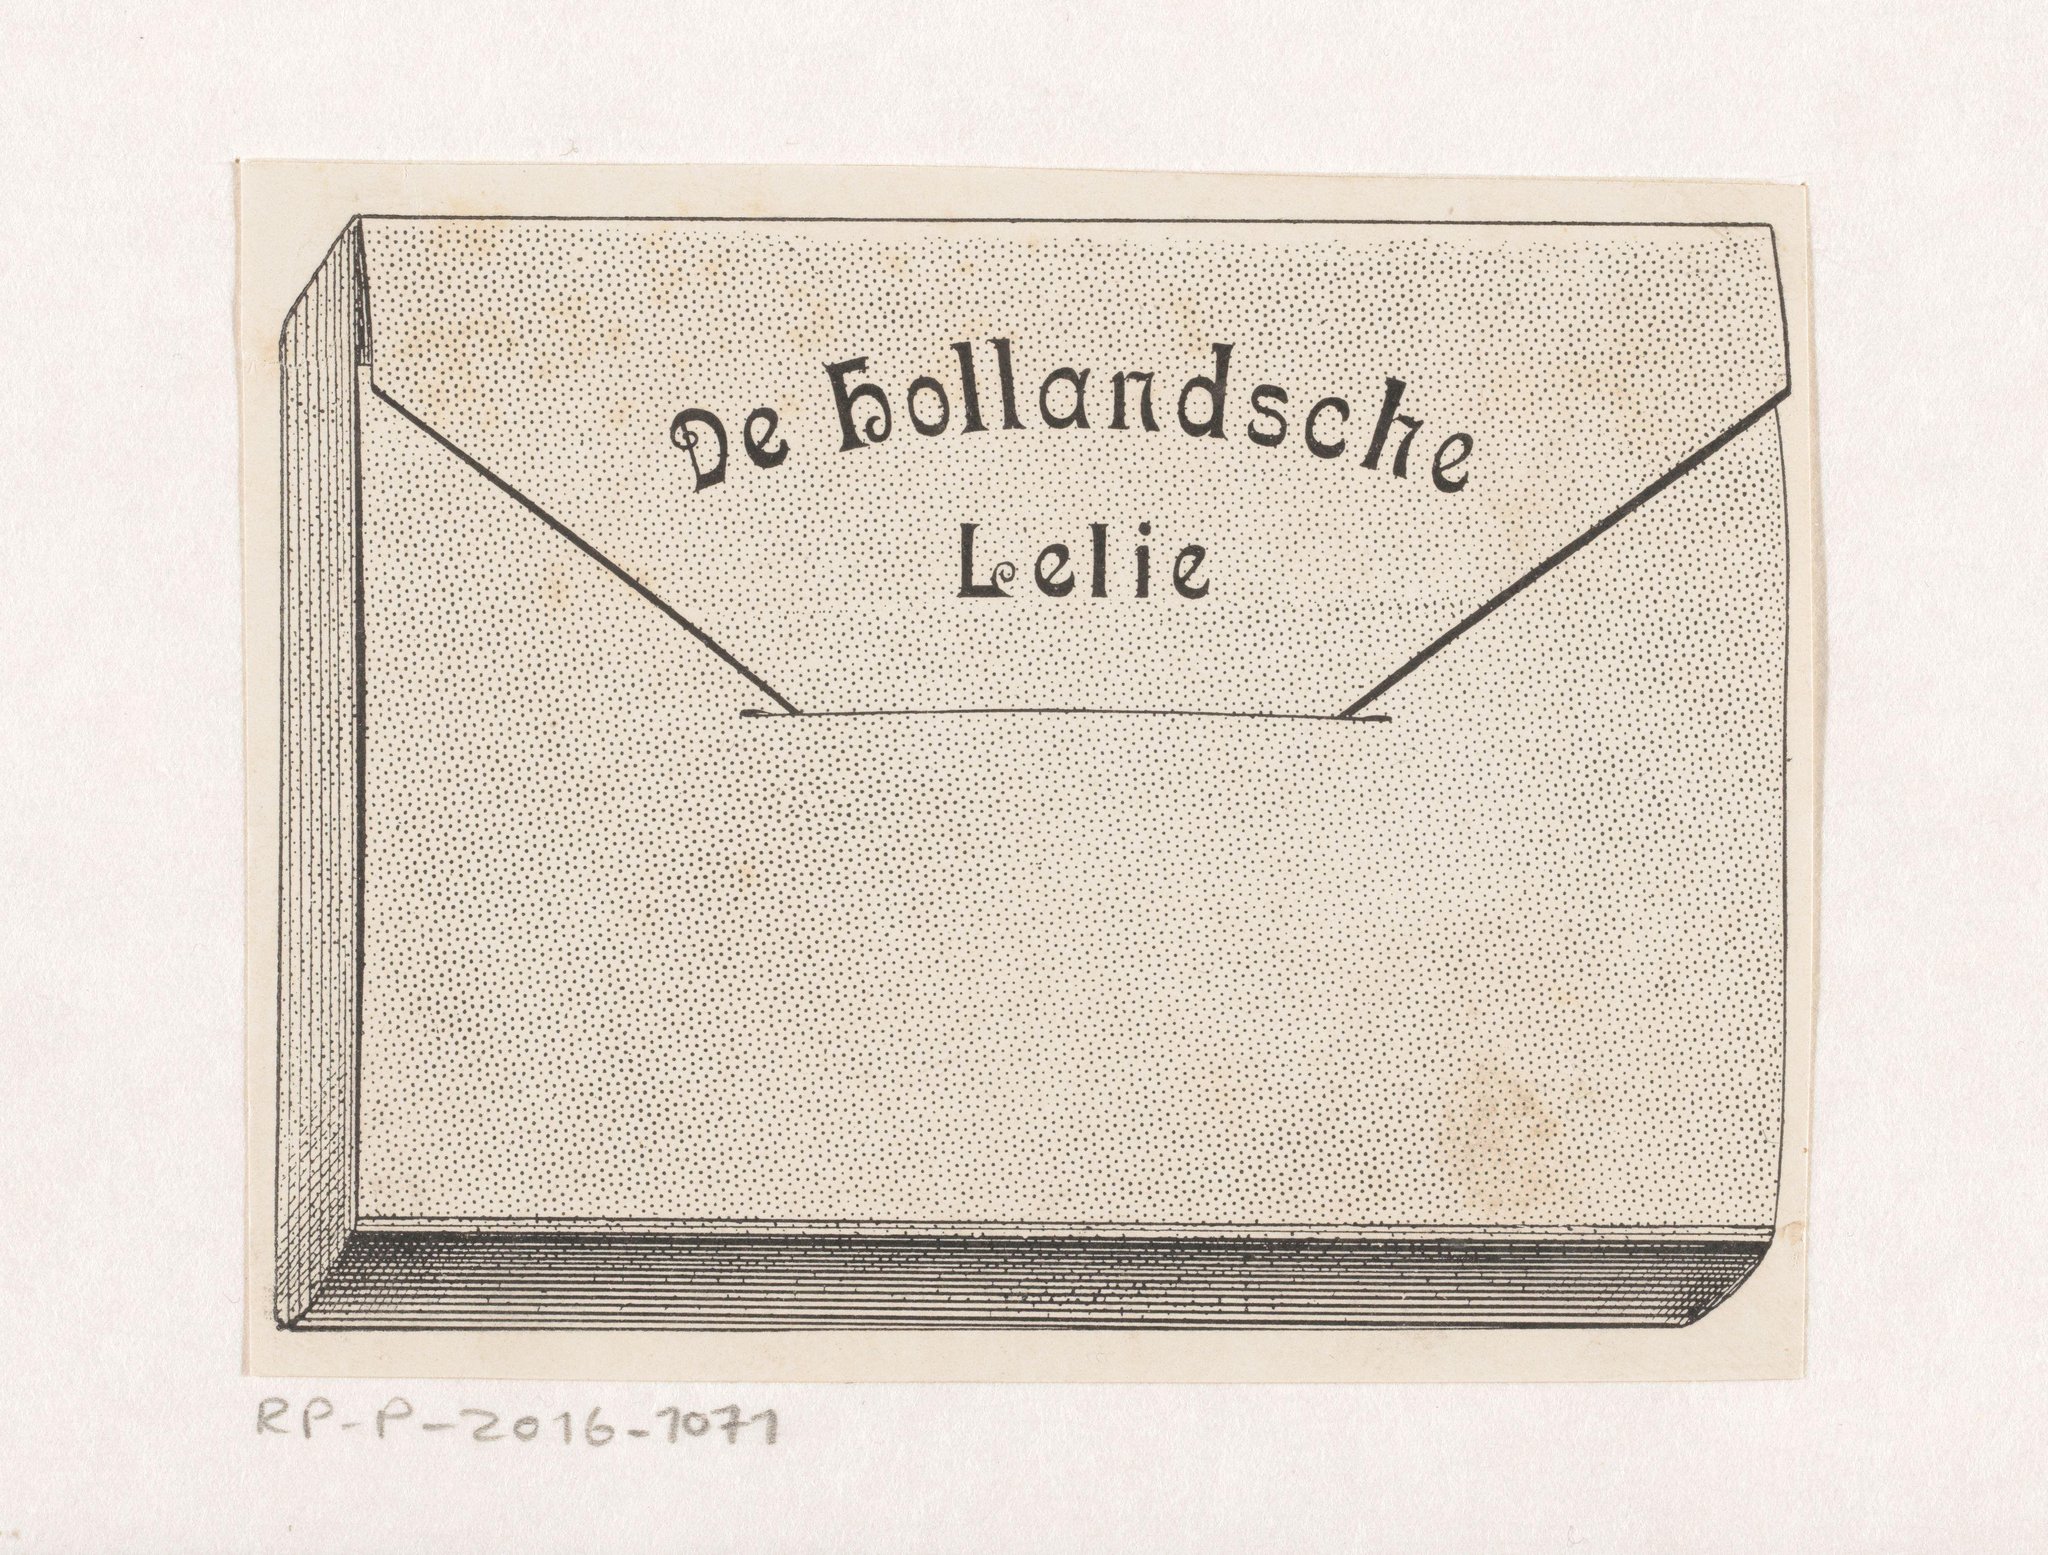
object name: photomechanical print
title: Map of envelop met 'De Hollandsche Lelie'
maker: Anonymous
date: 1870-1937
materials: paper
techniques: printing block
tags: letter, envelope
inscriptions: collector's mark: Lugt 2228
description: Een stapel mappen of enveloppen met op de achterzijde de tekst 'De Hollandsche Lelie'.